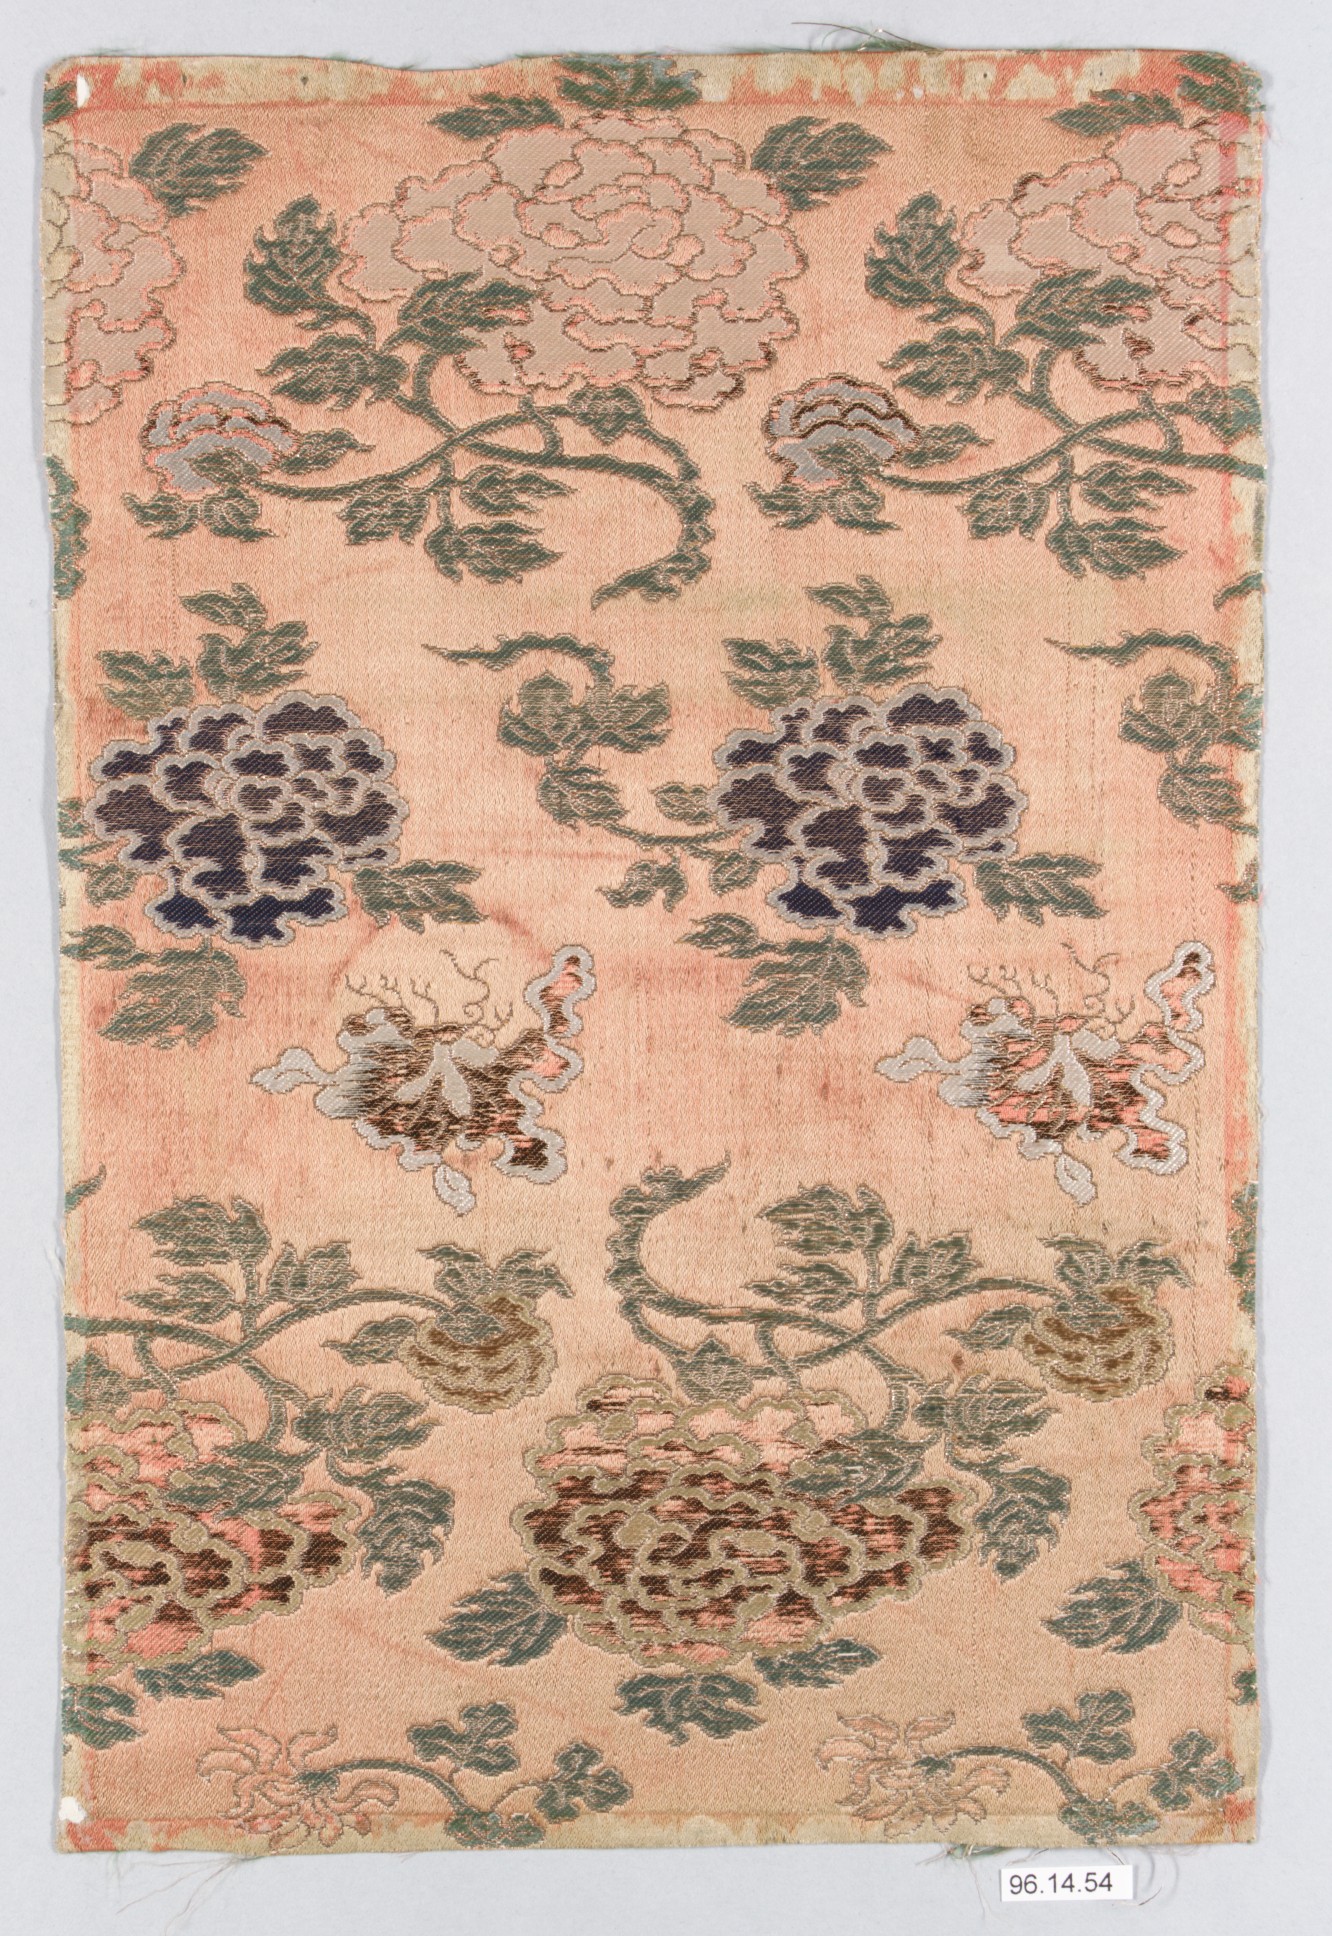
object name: piece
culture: chinese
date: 1701-1800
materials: metal thread, silk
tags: leaves